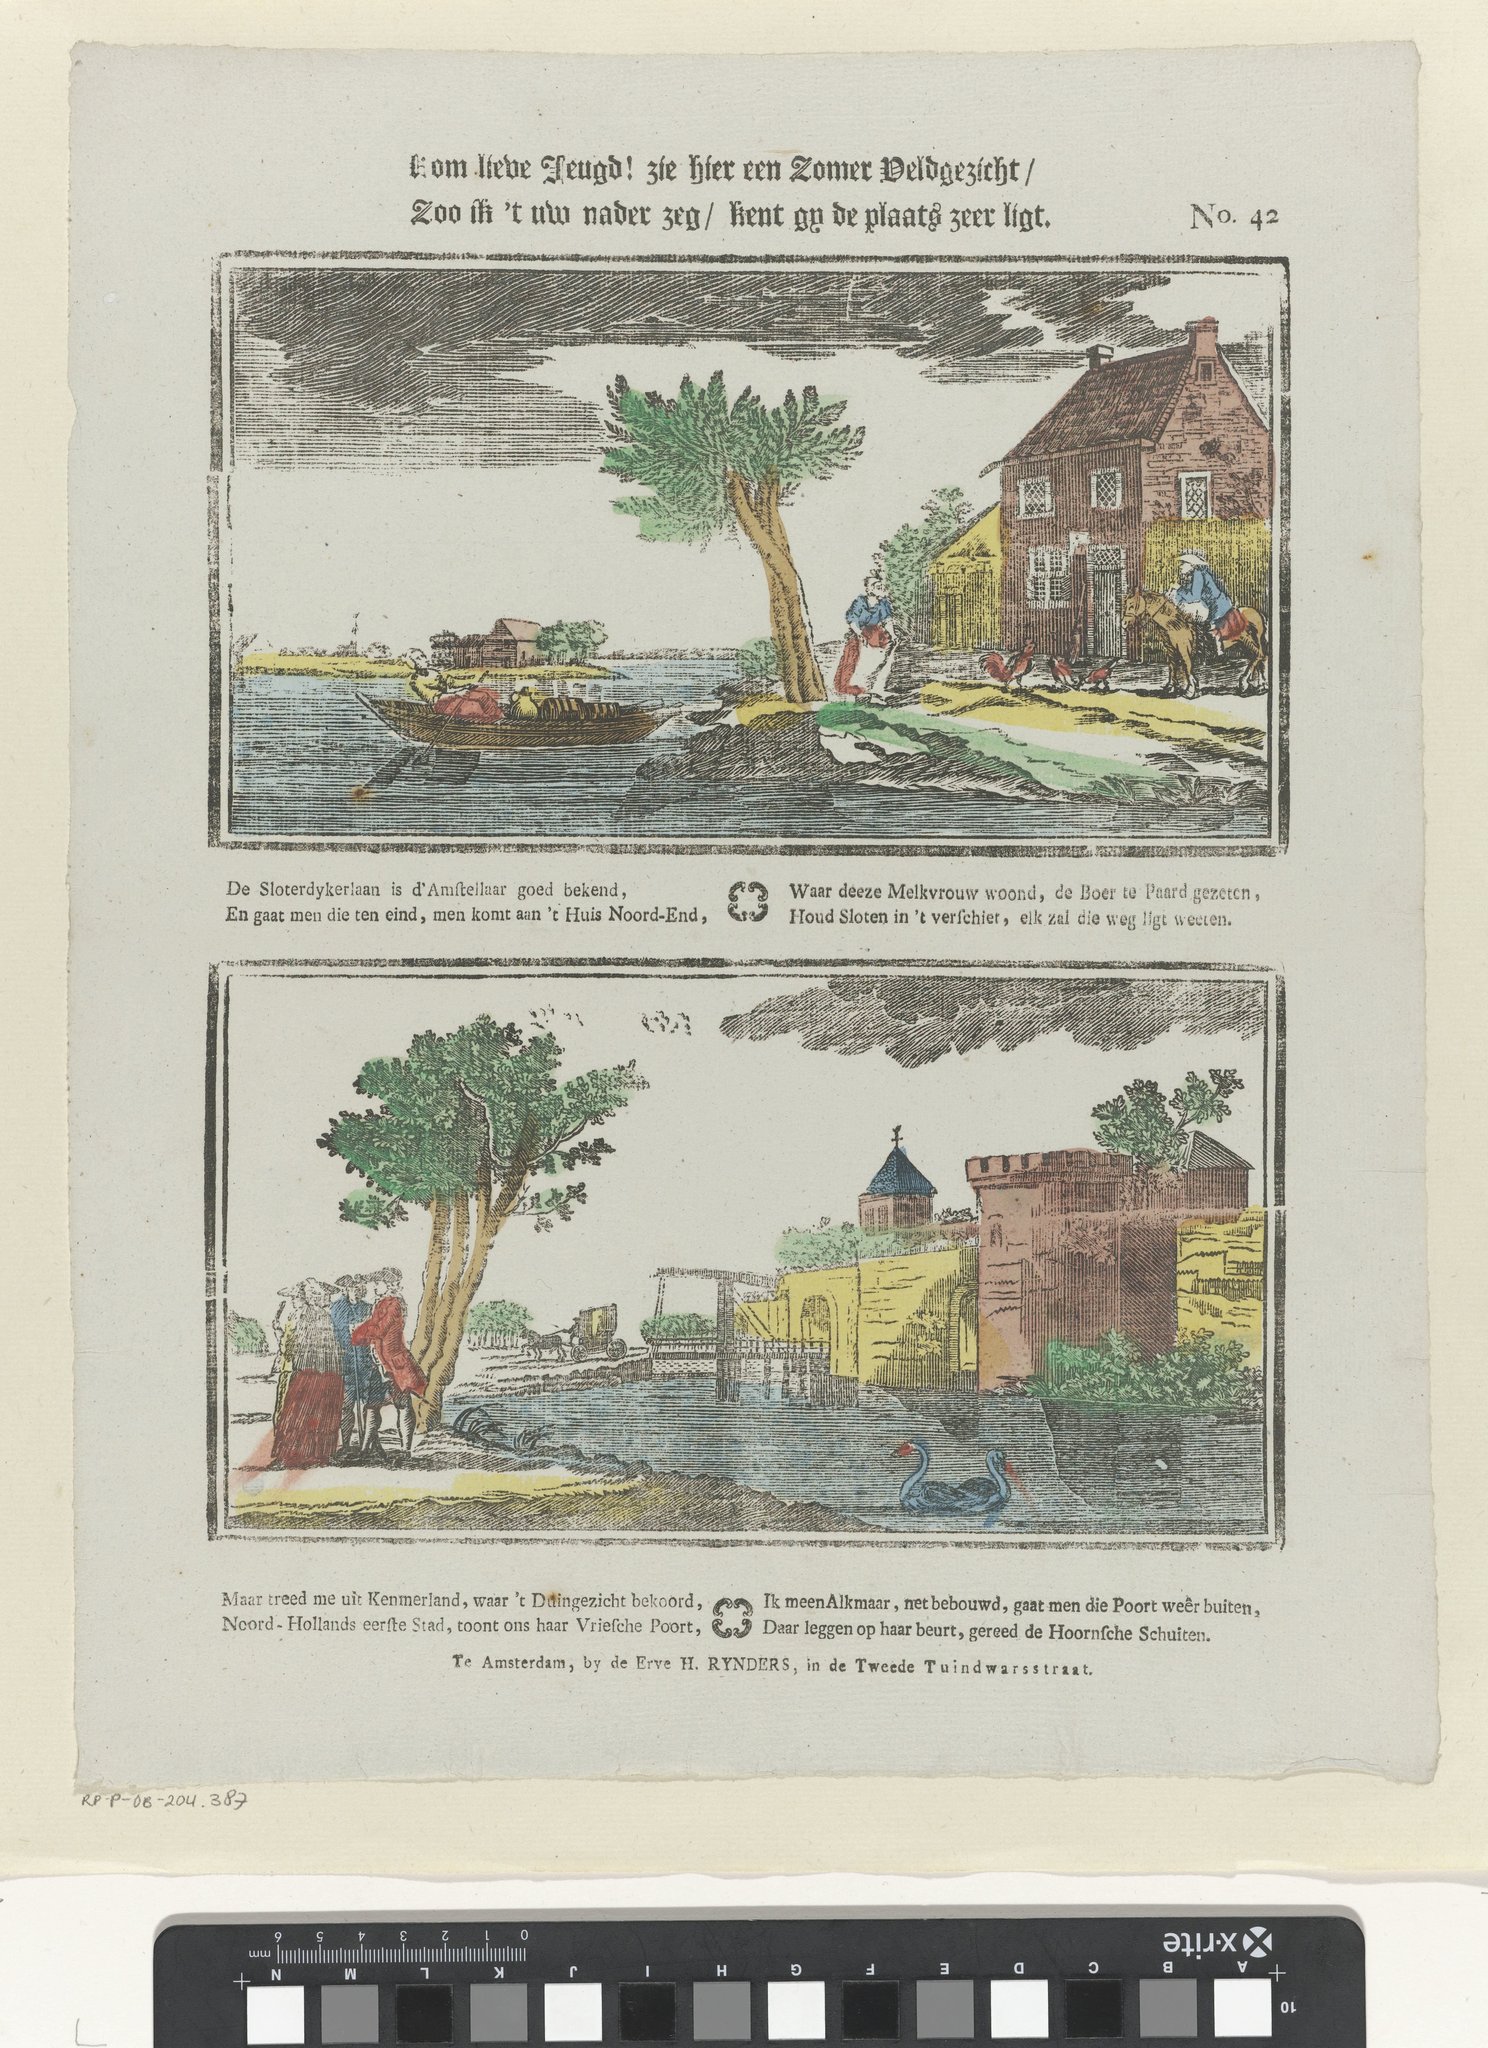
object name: print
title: Kom lieve jeugd! zie hier een zomer veldgezicht / Zoo ik 't uw nader zeg / kent gy de plaats zeer ligt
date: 1831-1854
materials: paper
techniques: colour, letterpress printing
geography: amsterdam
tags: city-view, and landscape with man-made constructions, city-gate, amsterdam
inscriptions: collector's mark: Lugt 2760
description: Blad met 2 voorstellingen van landschappen in de omgeving van Amsterdam en Alkmaar. Onder elke afbeelding een vierregelig onderschrift in twee kolommen. Genummerd rechtsboven: No. 42.